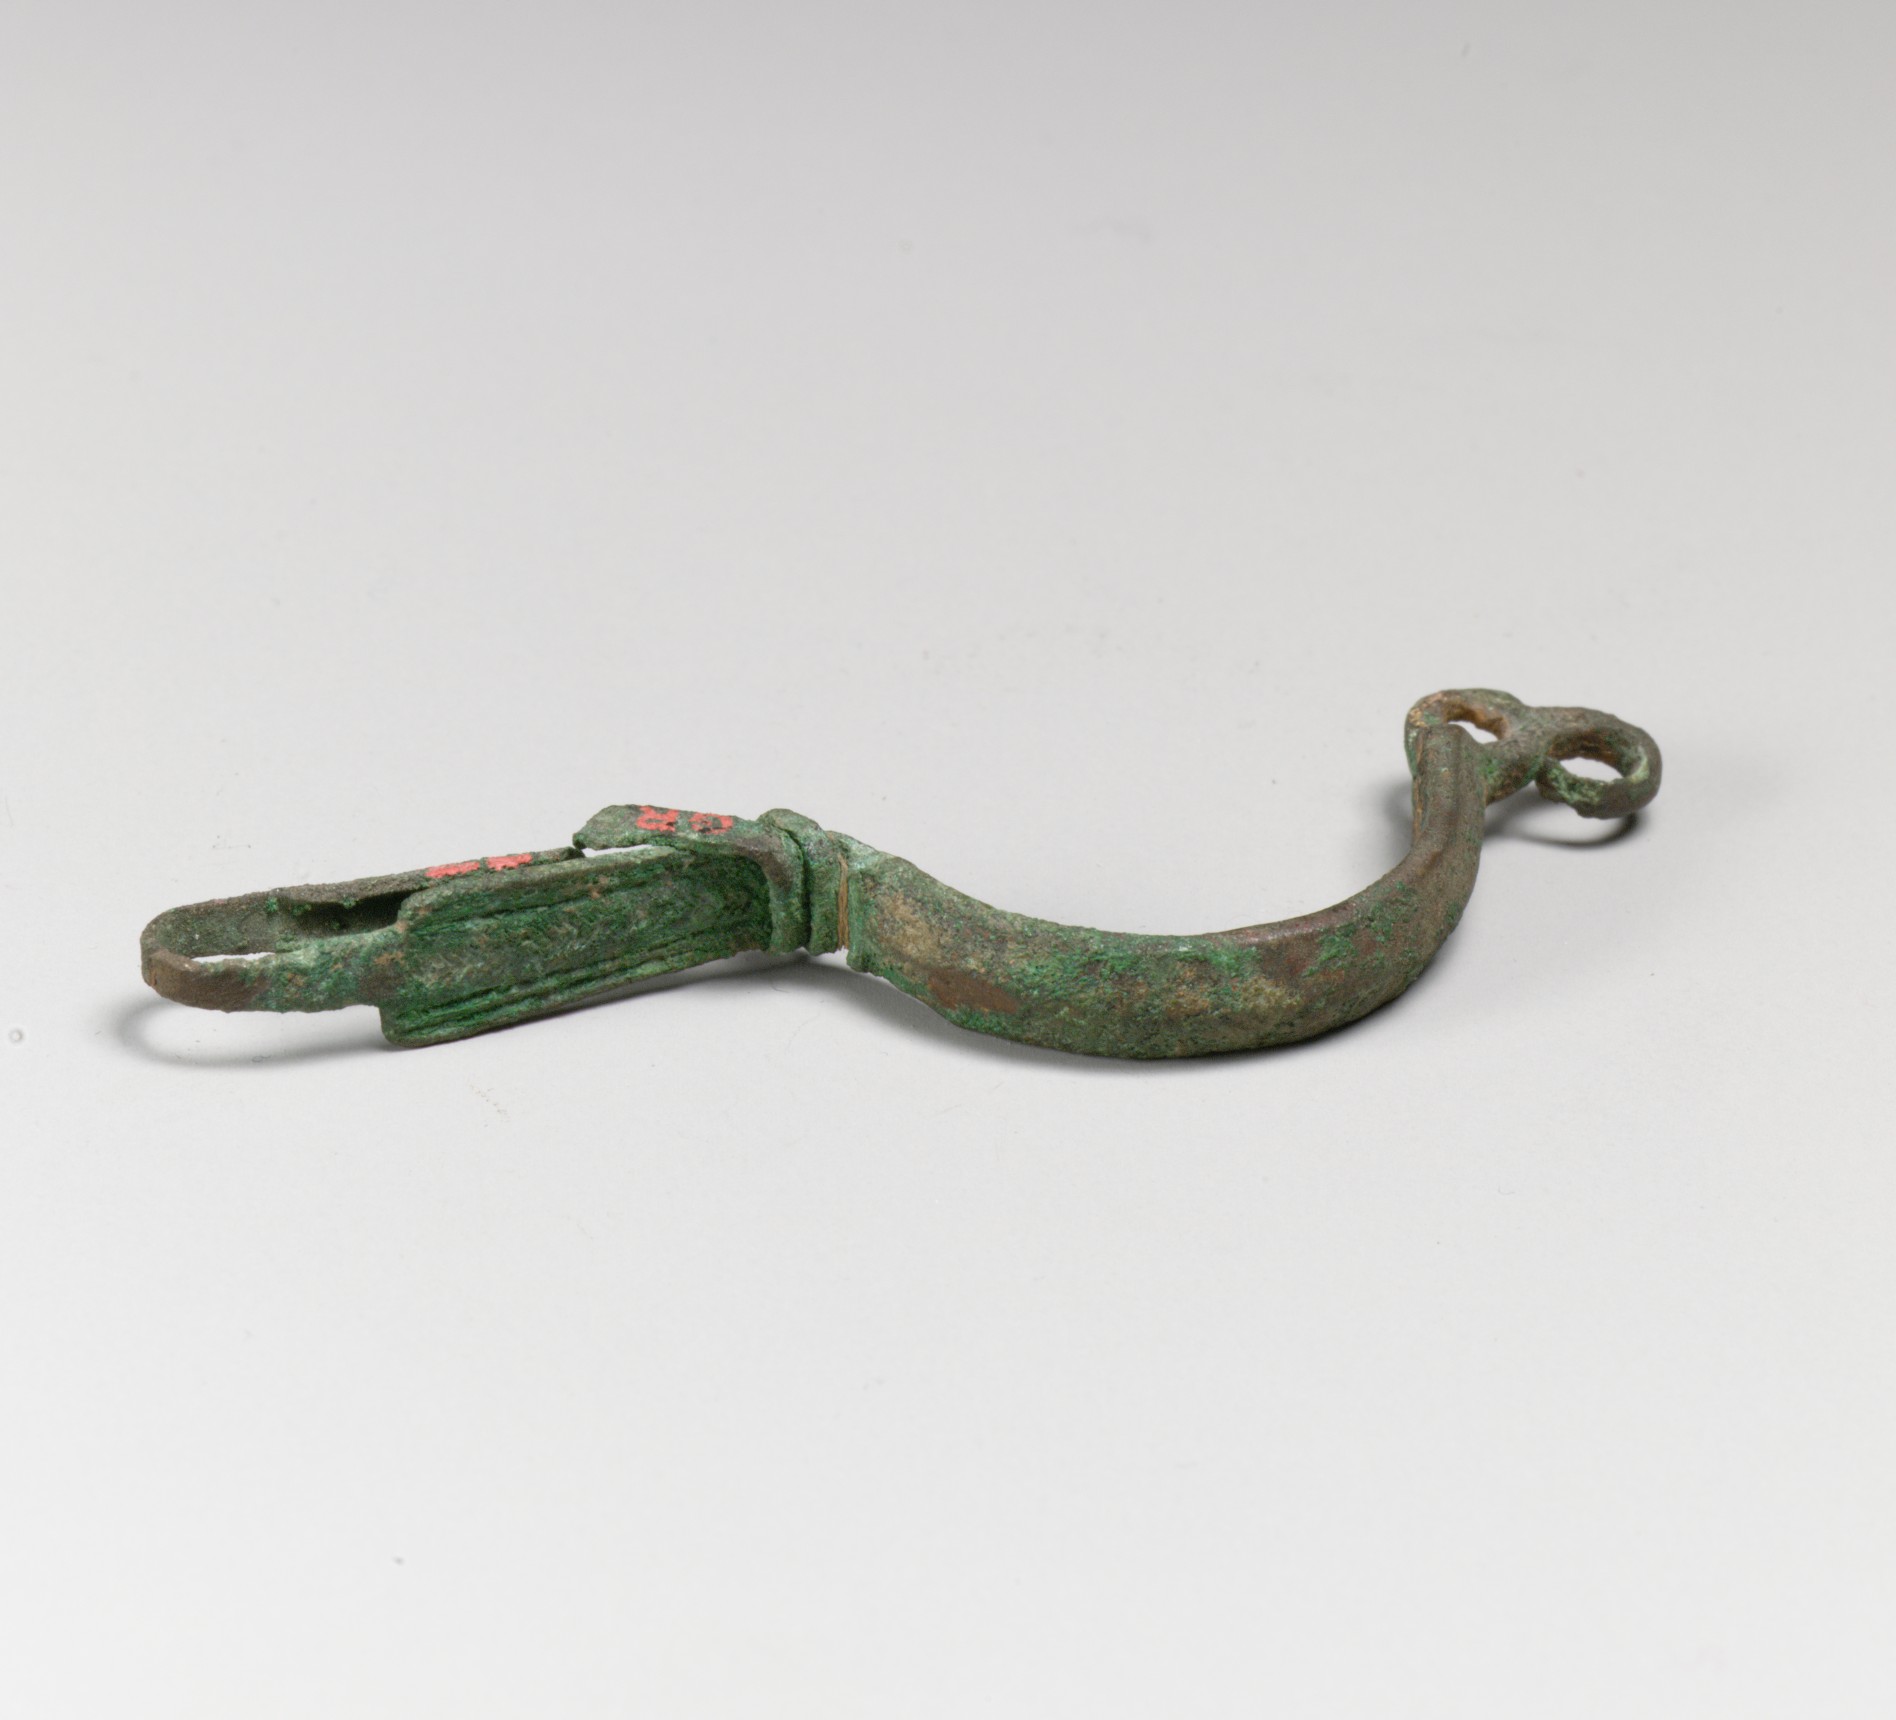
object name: fibula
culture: roman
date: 167-233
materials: bronze